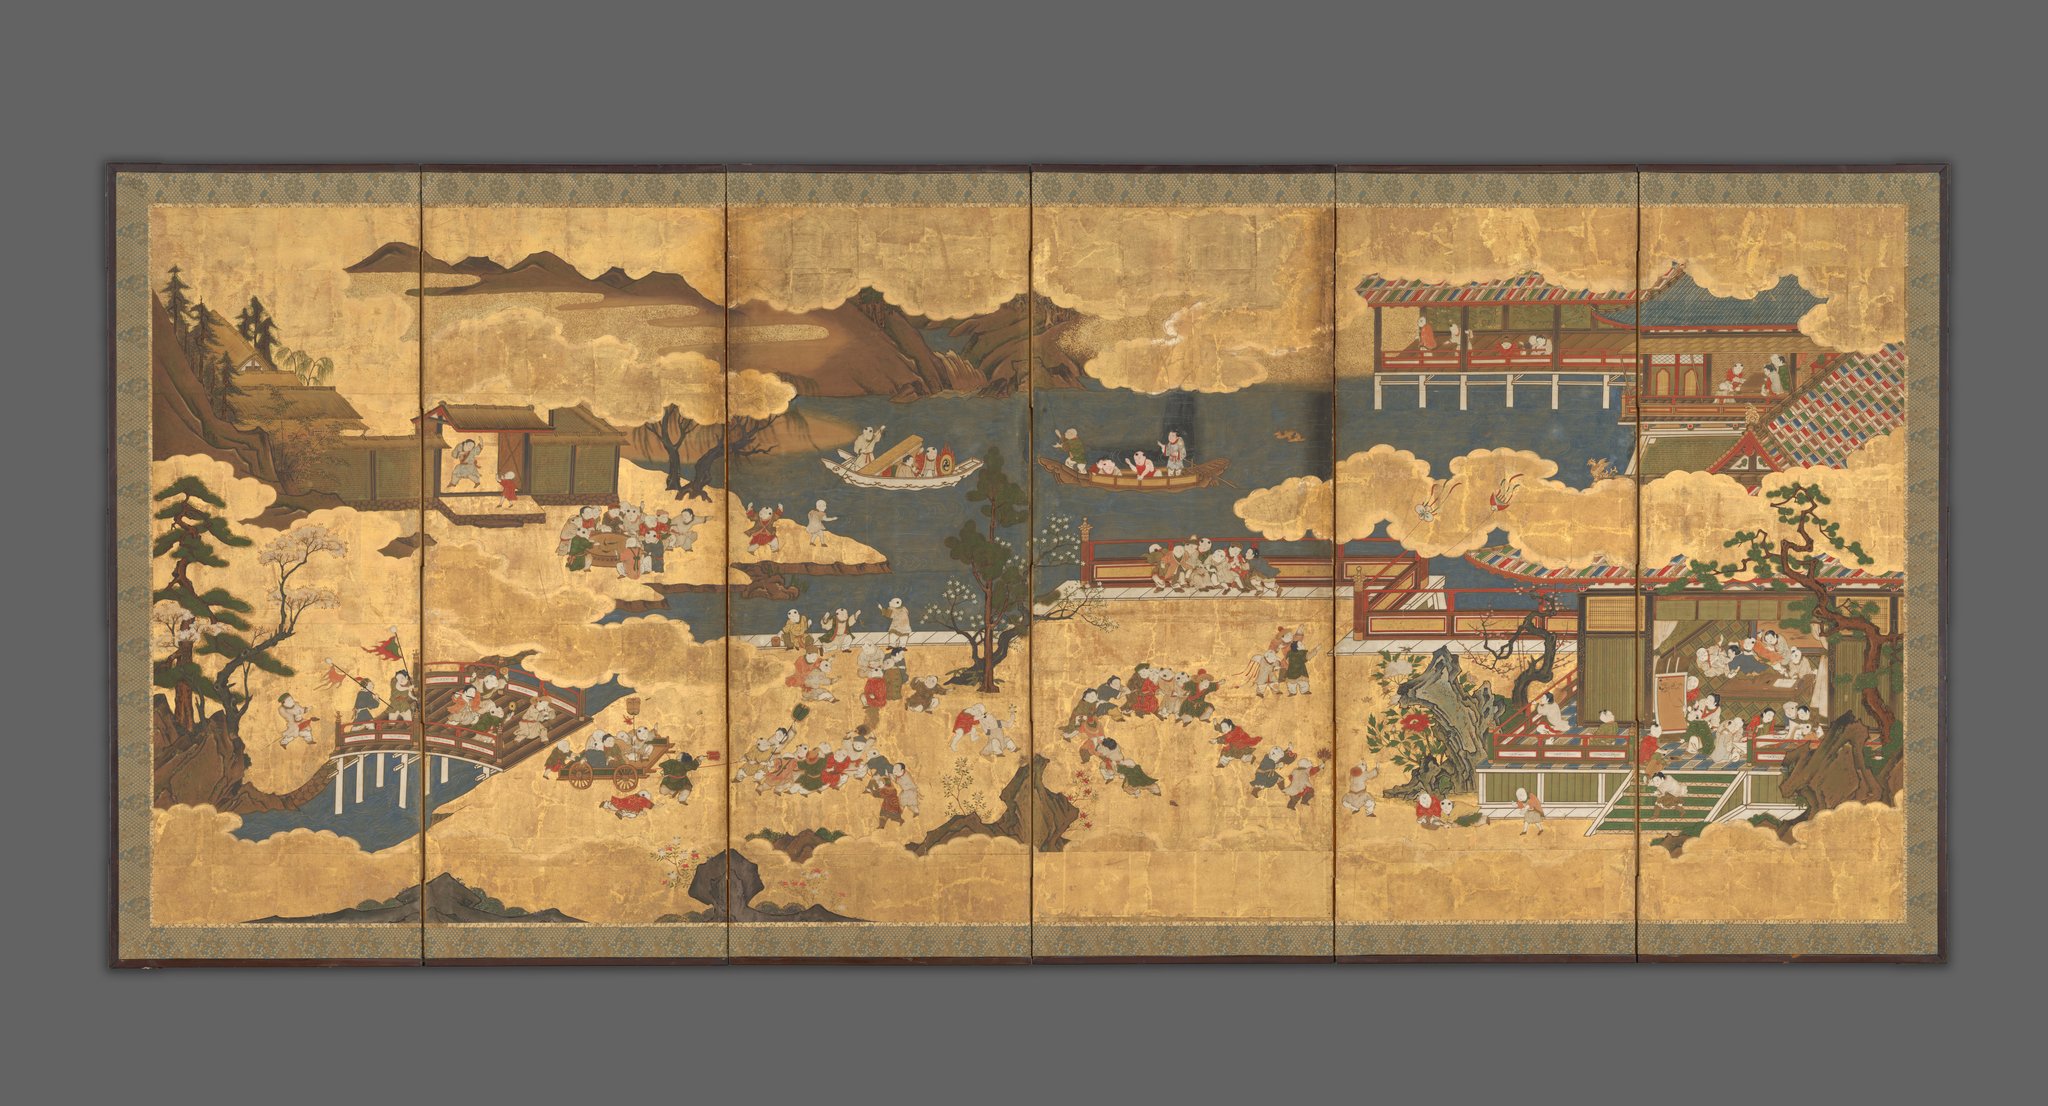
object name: screen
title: One Hundred Chinese Boys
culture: japanese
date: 1701-1800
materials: gold, ink, panel, paper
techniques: gilding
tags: bridges,boys,lakes,boats